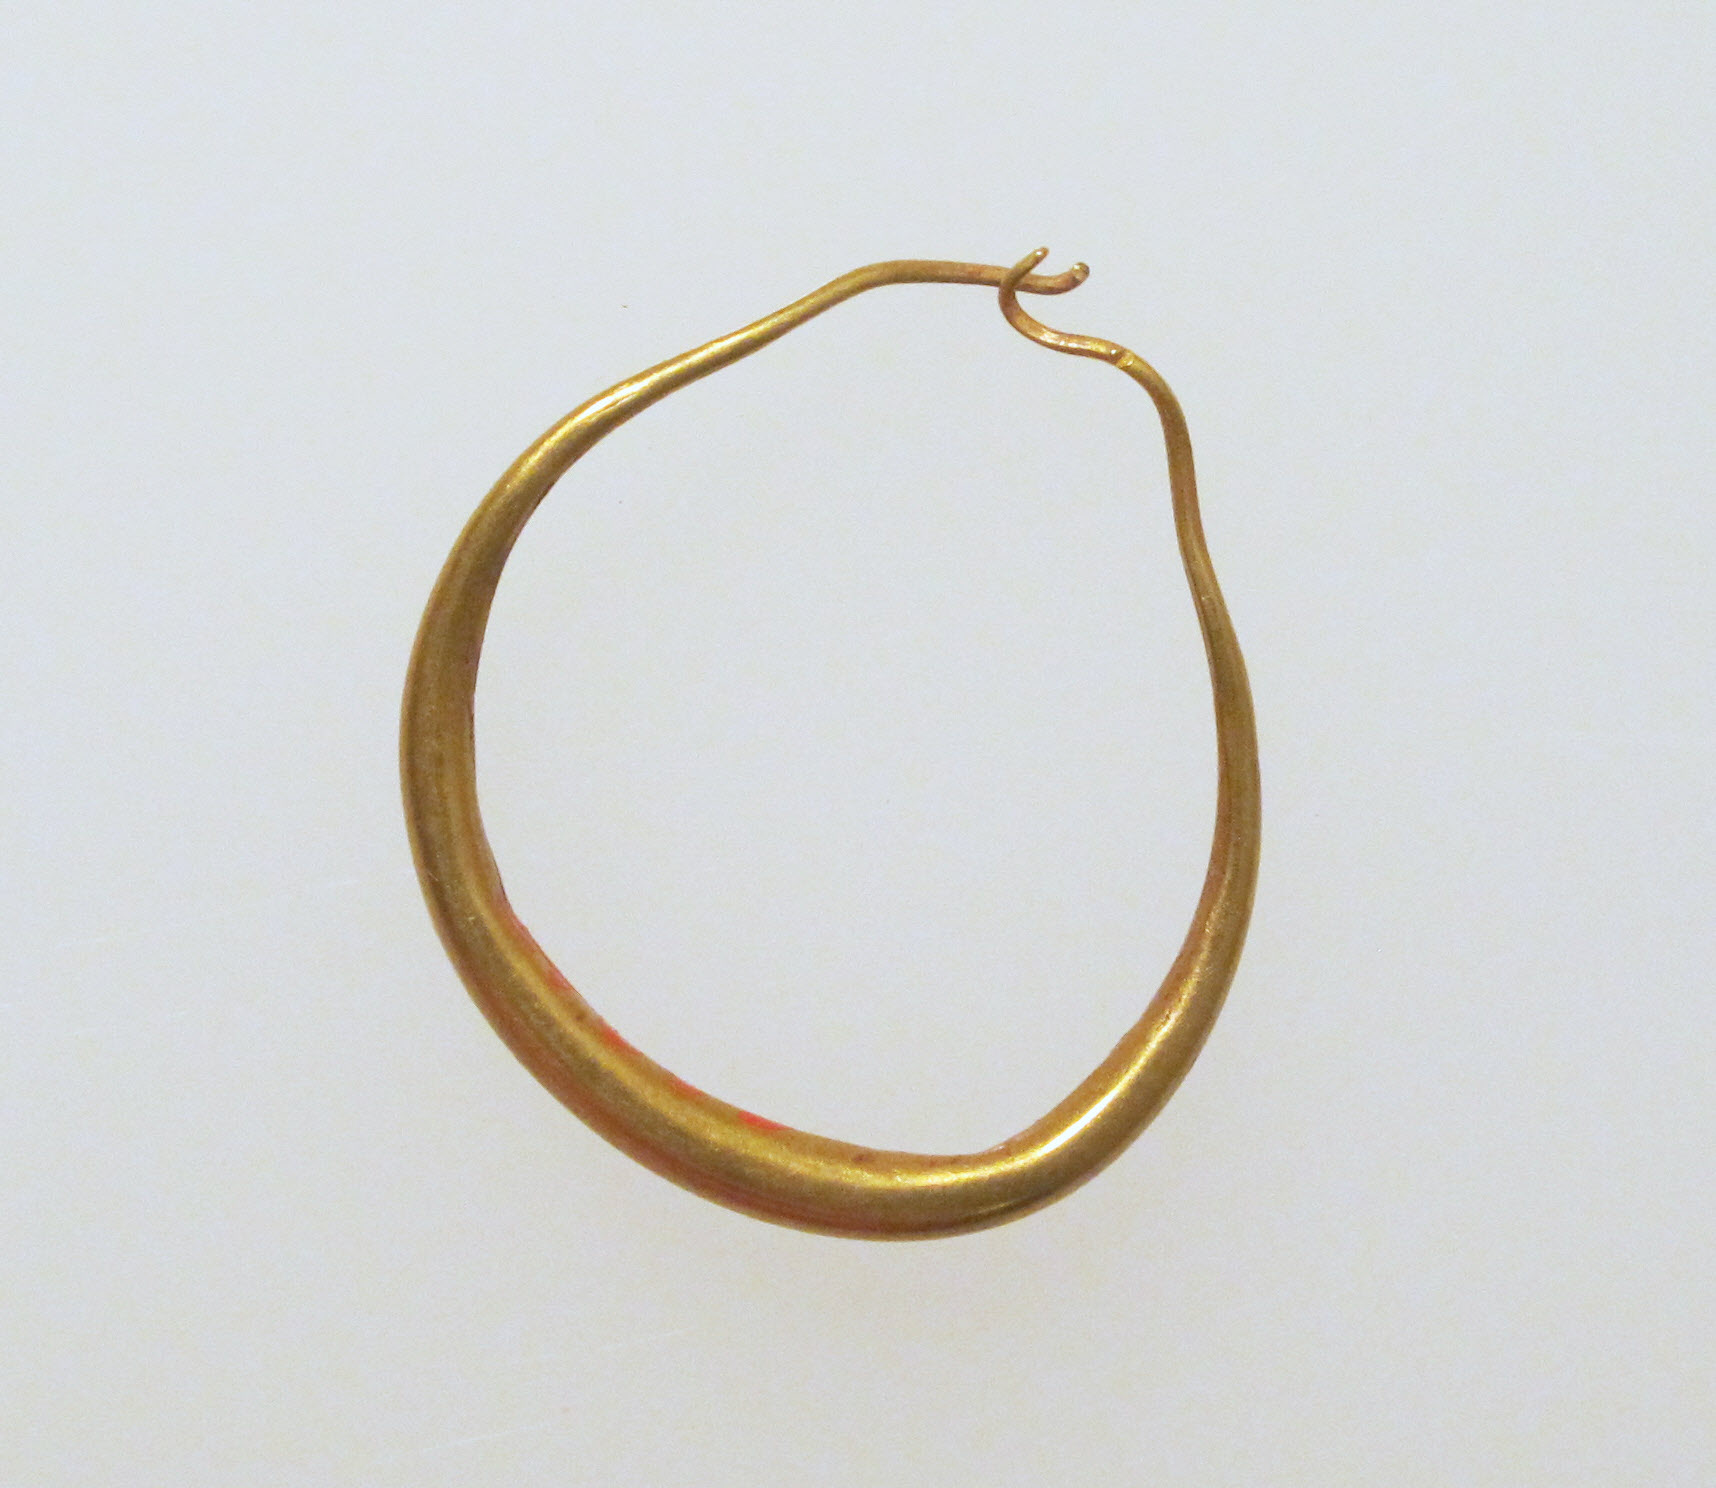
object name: earring loop type, plain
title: Earring-loop type, plain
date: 7000 BCE-330 CE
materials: gold